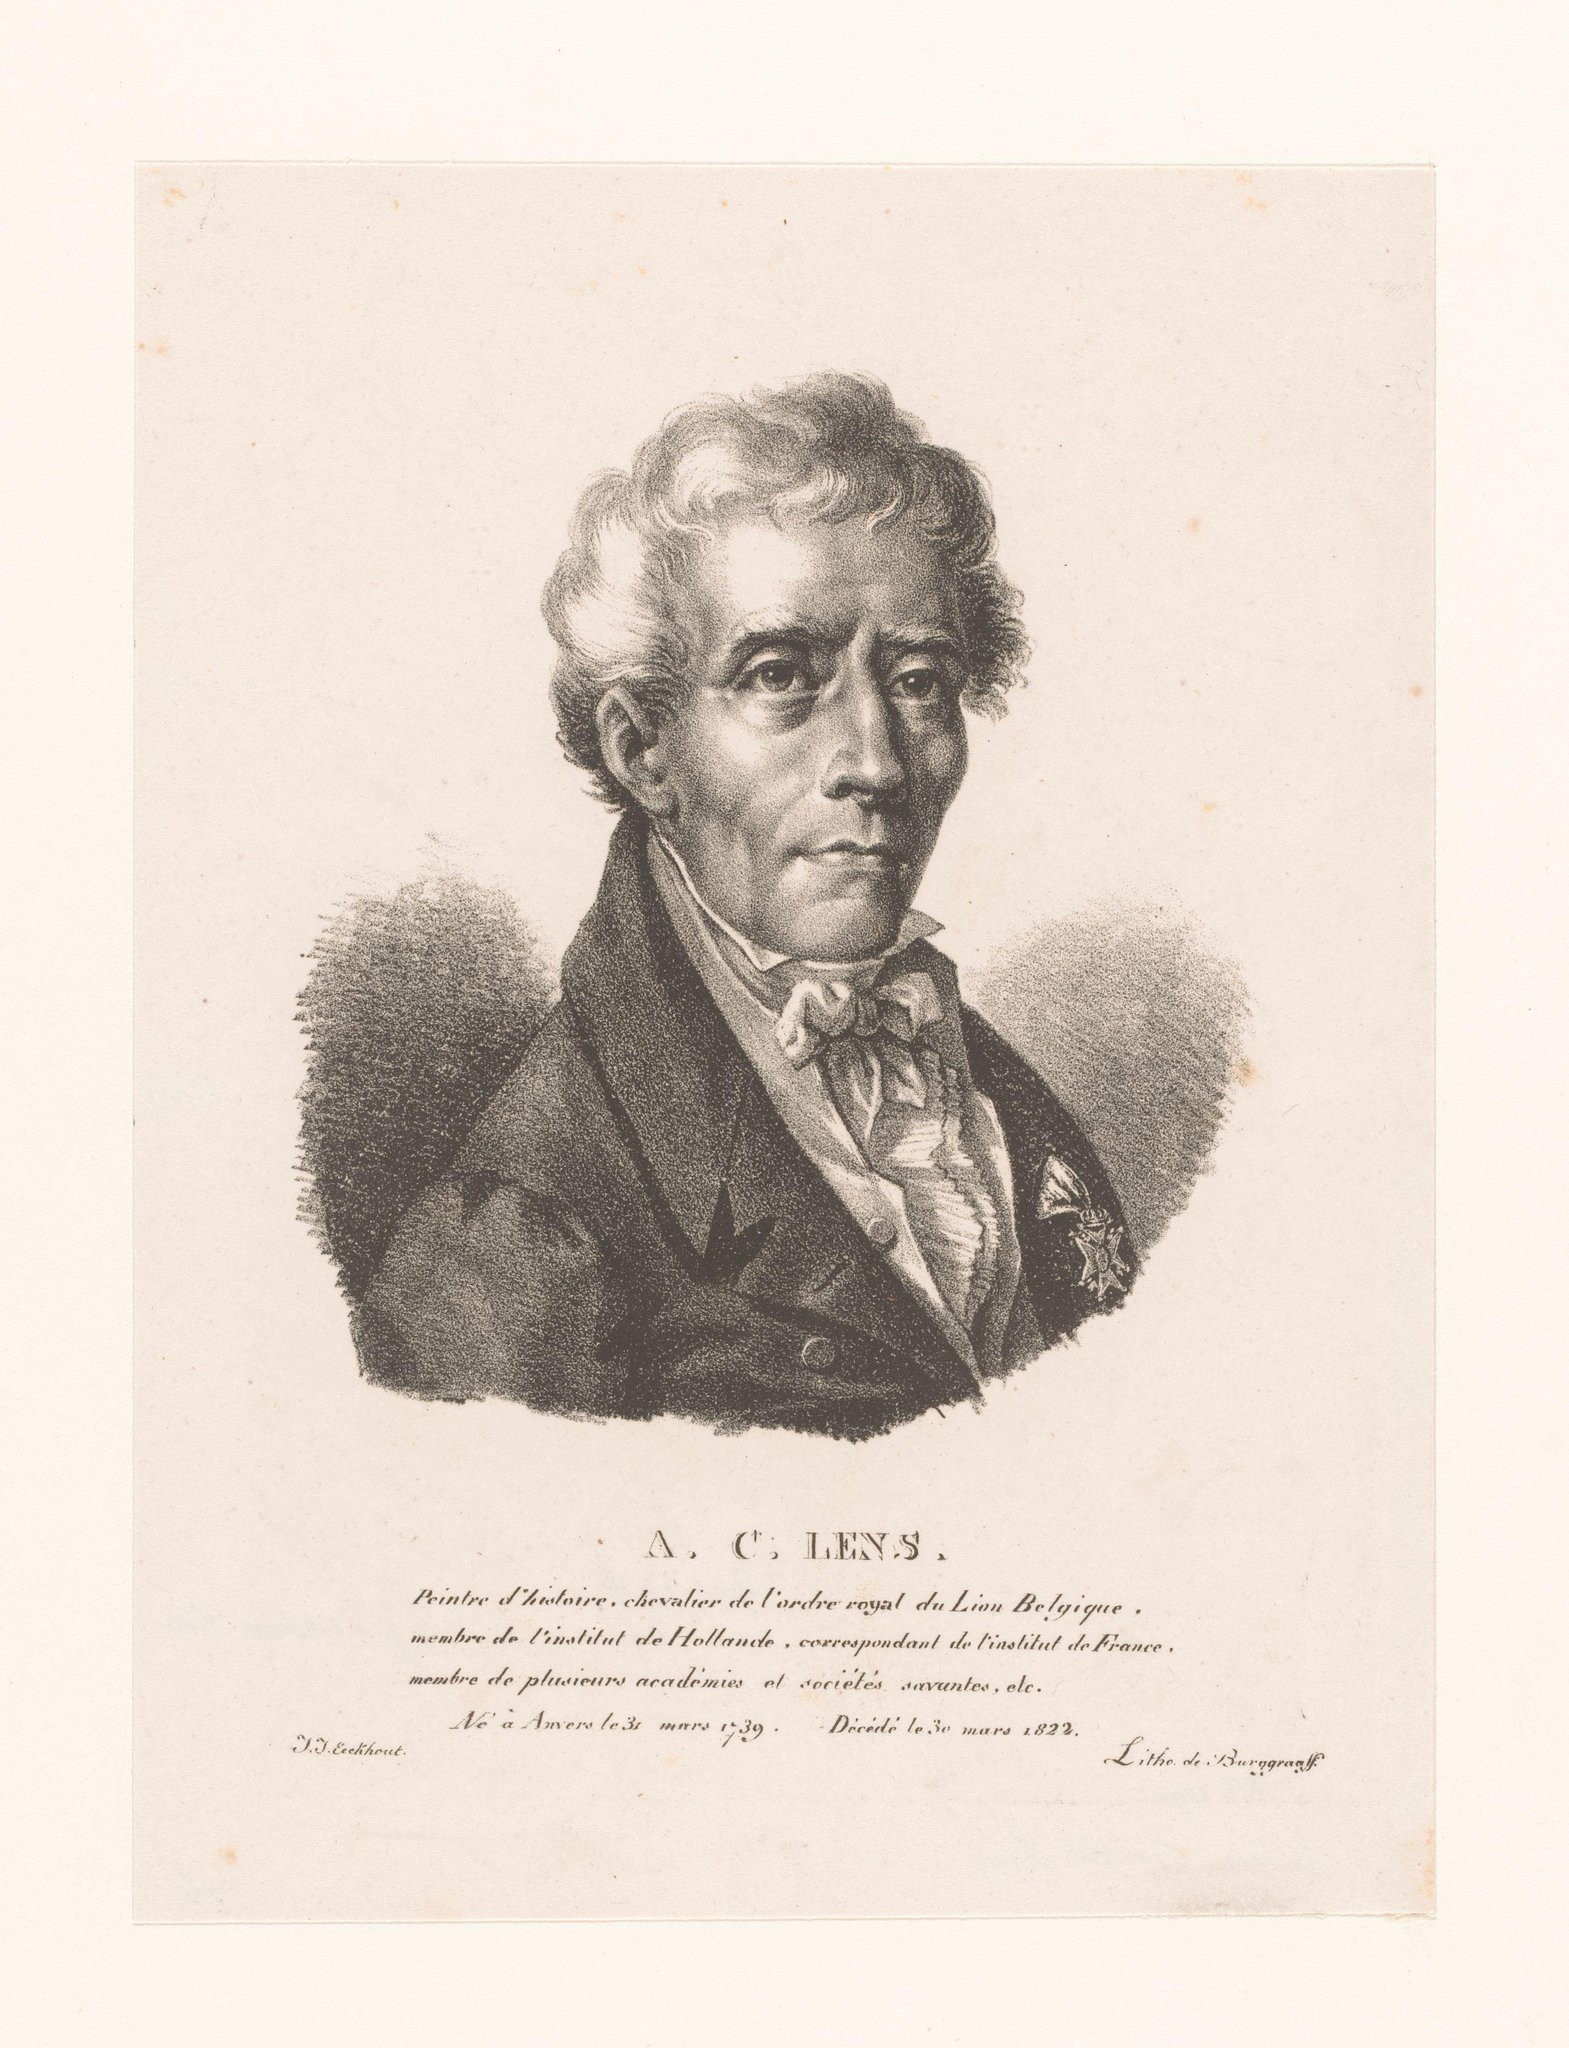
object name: print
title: Portretten van hedendaagse kunstenaars uit het Verenigd Koninkrijk der Nederlanden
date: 1822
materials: paper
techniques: lithograph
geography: brussels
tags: antwerp, brussels, andries lens, historical persons, portrait, self-portrait of painter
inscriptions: collector's mark: Lugt 2760, collector's mark: Lugt 2228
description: Prent maakt deel uit van een serie van zestig prenten.